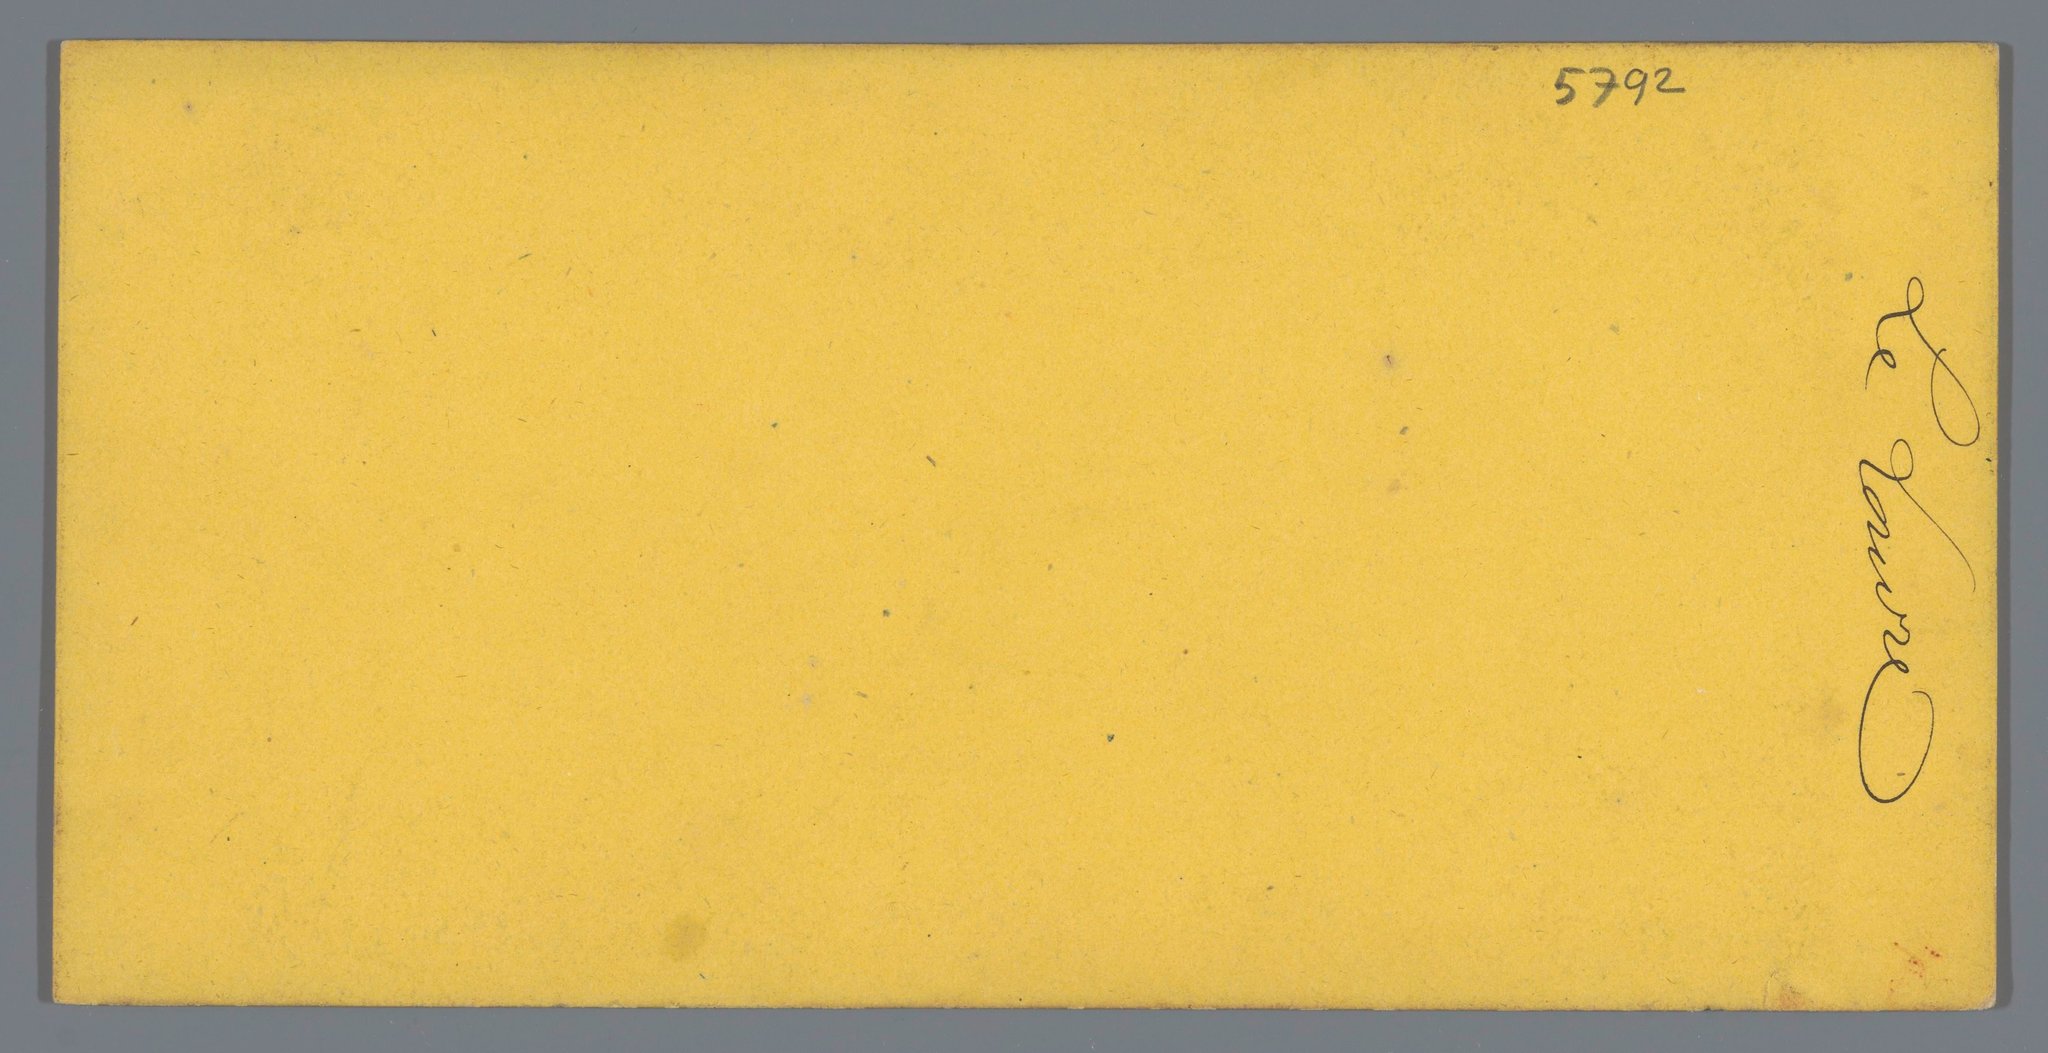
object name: stereograph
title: Les Monuments de Paris Collection Nouvelle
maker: Anonymous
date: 1850-1870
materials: cardboard, photographic support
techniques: albumen print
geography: paris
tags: permanent exhibition, museum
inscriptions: inscription: ‘Le Louvre’